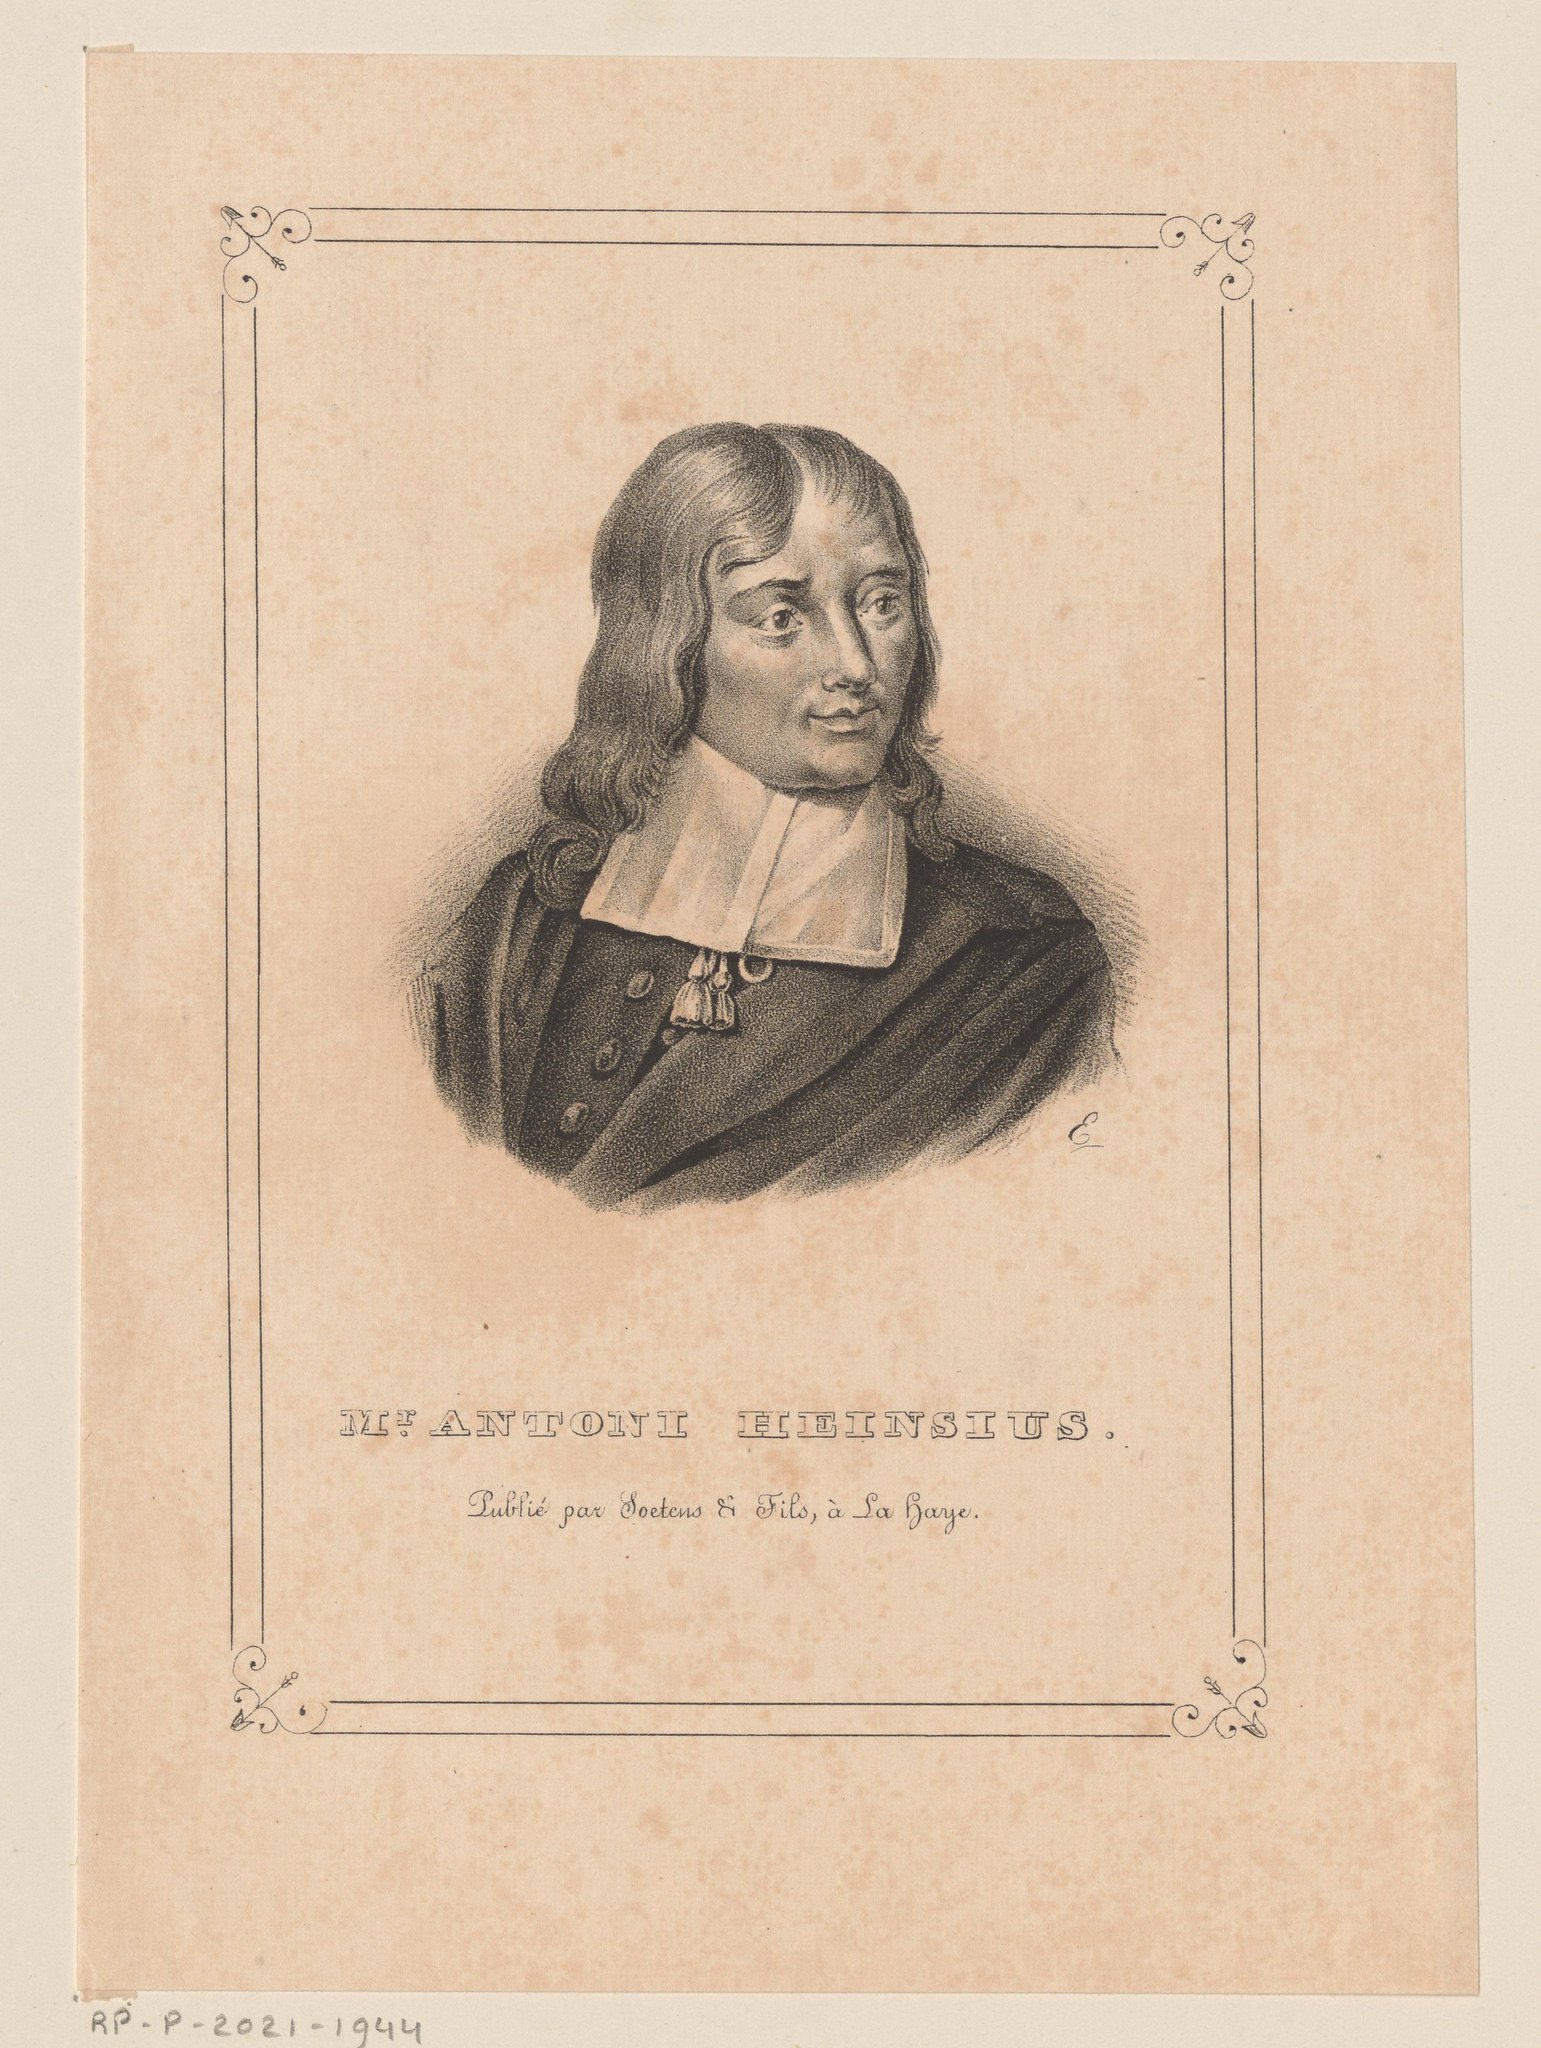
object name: print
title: Portret van Anthonie Heinsius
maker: gerhardus fredericus eilbracht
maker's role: draughtsman, print maker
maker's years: 1816-1854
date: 1837-1840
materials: paper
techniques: lithograph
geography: the hague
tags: delft, the hague, anthonie heinsius, historical persons